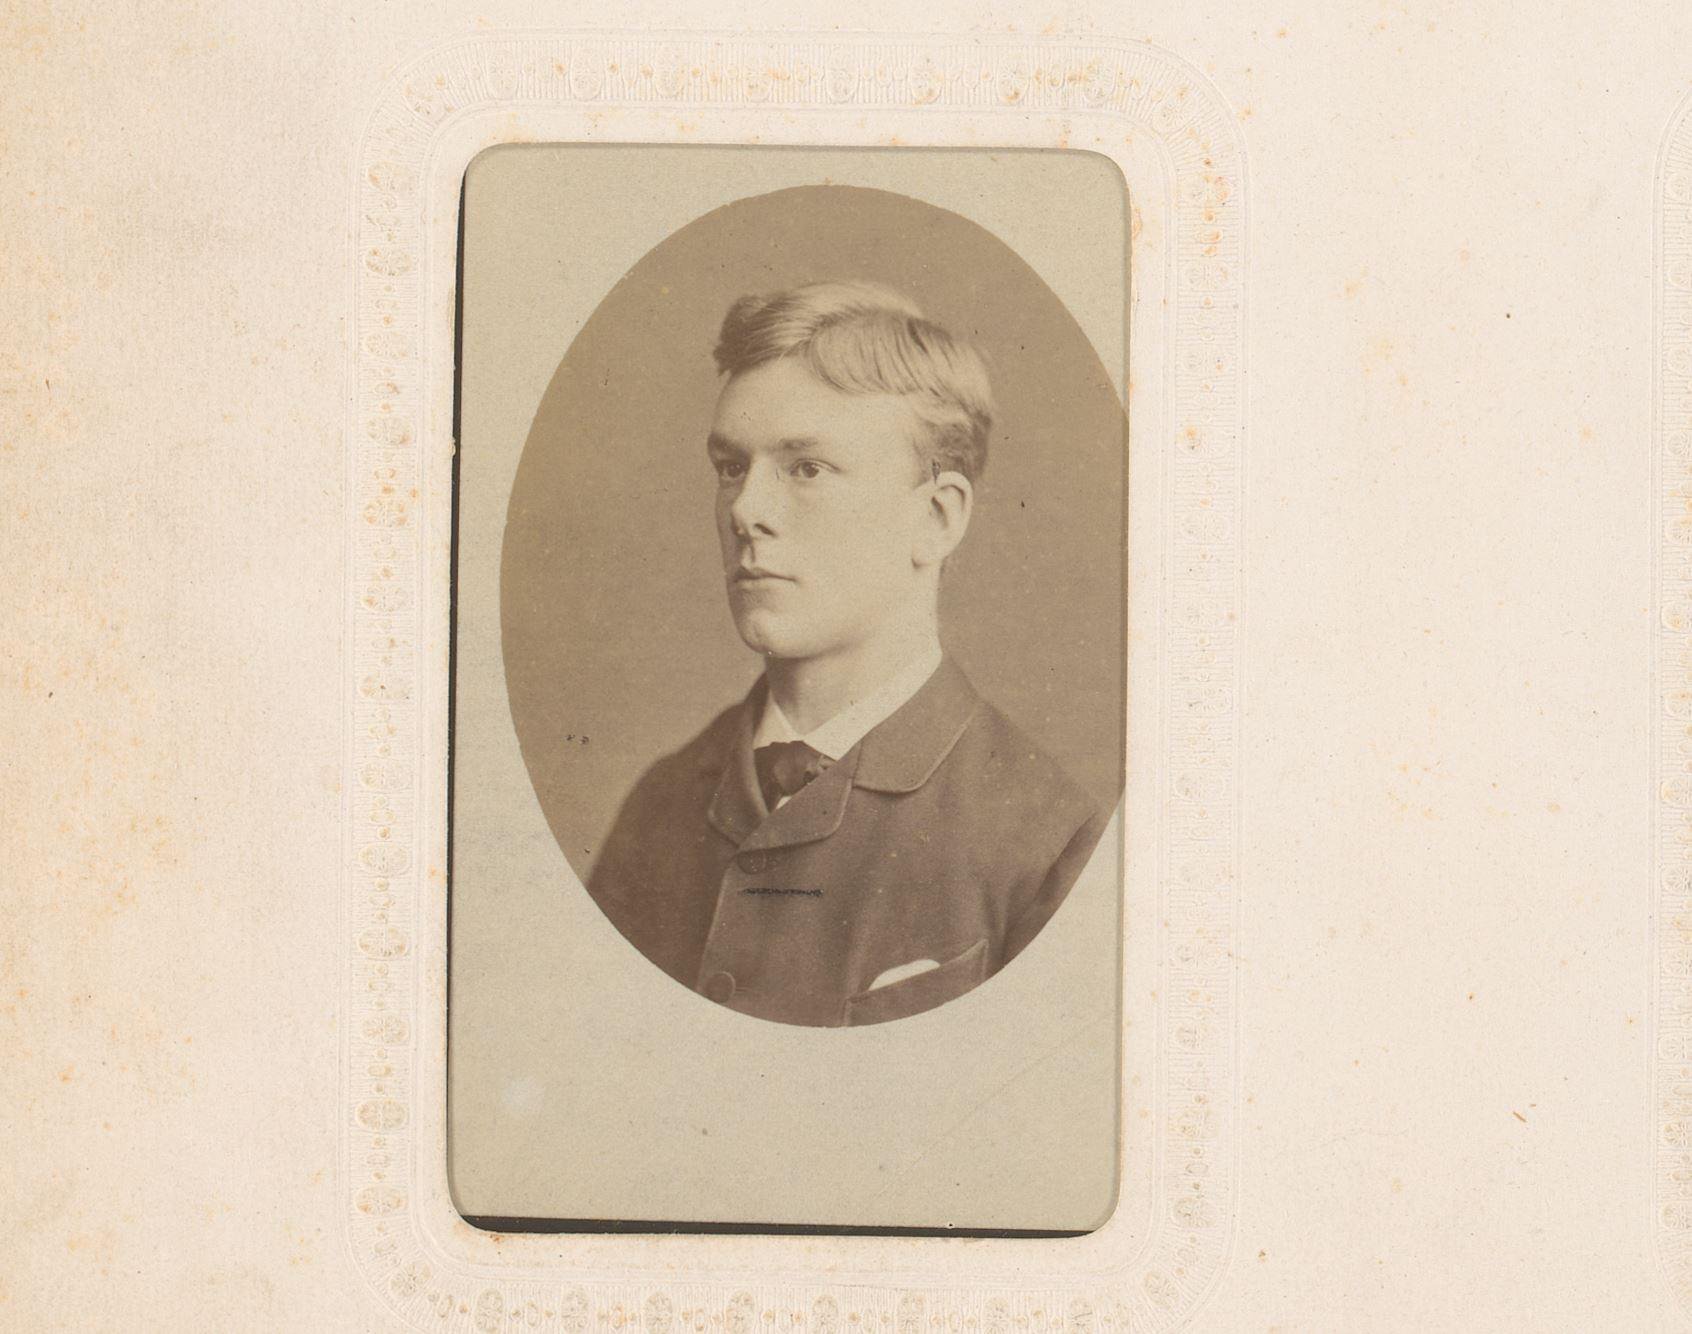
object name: carte de visite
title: Portret van een jonge man, aangeduid als oom Frans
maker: Anonymous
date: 1860-1900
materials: cardboard, photographic support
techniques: albumen print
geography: netherlands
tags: historical persons, youth, adolescent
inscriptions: name: ‘Oom Frans’